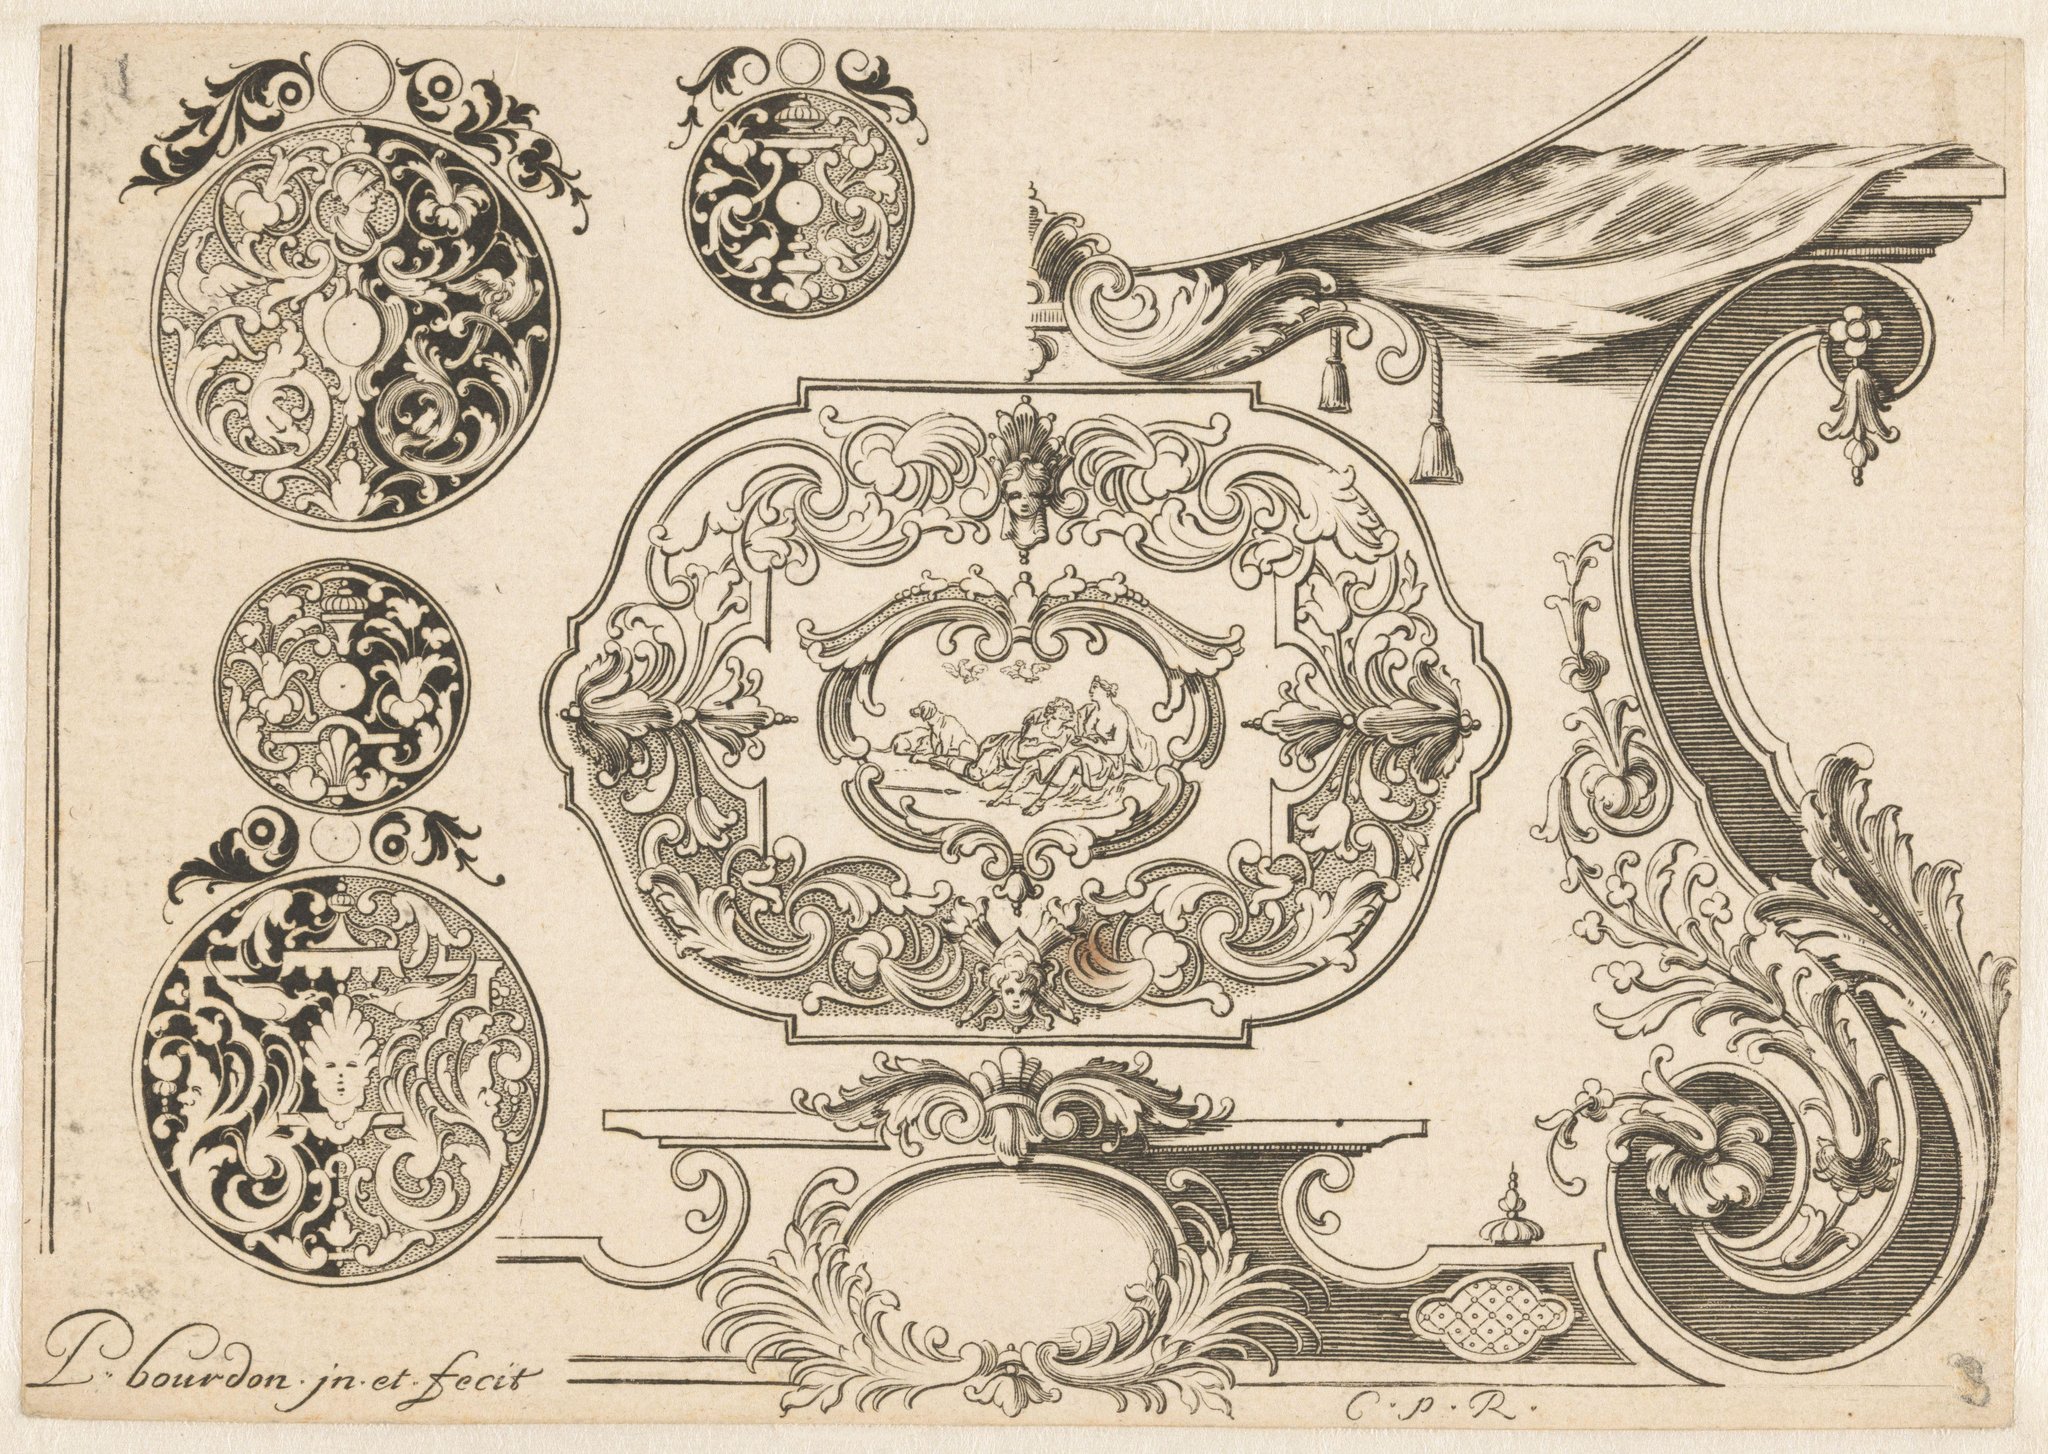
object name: print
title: Ontwerpen voor horlogekasten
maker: pierre bourdon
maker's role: print maker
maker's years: 1656-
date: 1703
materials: paper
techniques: engraving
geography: paris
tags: ornaments ~ art, watch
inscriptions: collector's mark: Lugt 2228, signature: ‘P. bourdon in et fecit’, privilege: ‘C.P.R.’, number: ‘3’, collector's mark: Lugt 2760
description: Blad uit serie van zeven van ontwerpen voor horlogemakers, goudsmeden, beeldhouwers en graveurs.